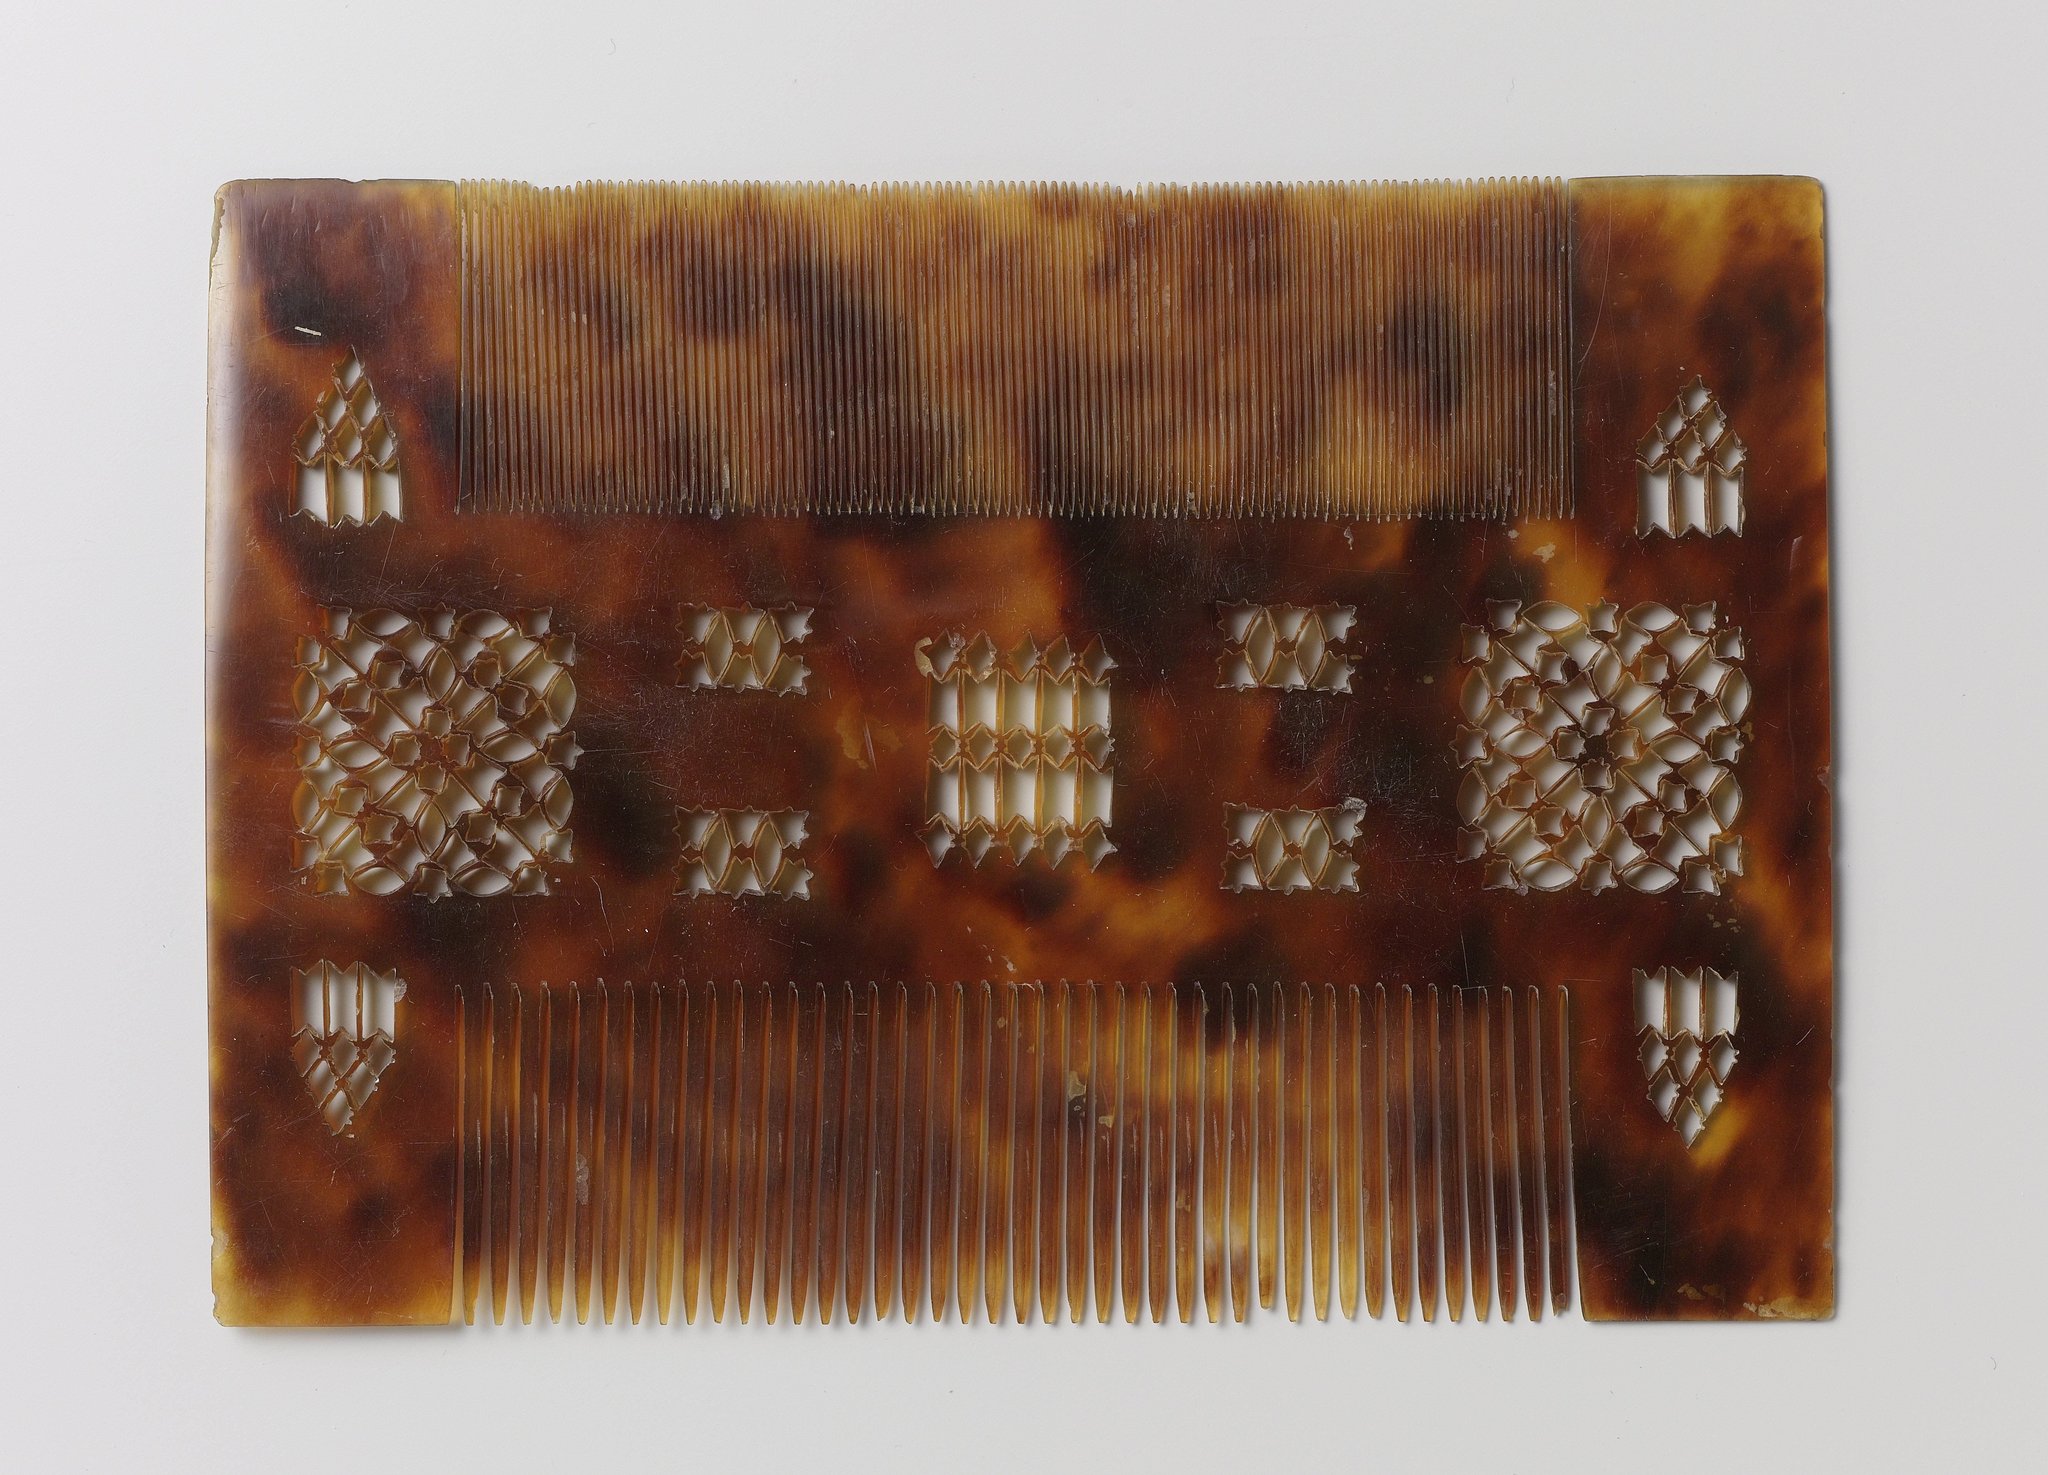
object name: toiletry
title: Haarkam van schildpad met een ajour gesneden middenveld en aan weerszijden tanden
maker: Anonymous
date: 1500-1524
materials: shell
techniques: embroidery, filing, polish, sawing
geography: southern europe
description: Kam van schildpad met een ajourgesneden middenveld en aan weerszijden tanden. In een tijd dat haren niet of nauwelijks werden gewassen werd een kam allereerst gebruikt om het haar te reinigen: te ontdoen van viezigheid en ongedierte. Daarom verschilt ook de dikte van en de afstand tussen de tanden aan weerszijden. Schildpad was een geliefd, maar kostbaar materiaal dat van ver moest komen. Dit blijkt uit een brief die een Antwerpse kunsthandelaar in juni 1640 kreeg van zijn agent in Lissabon. Deze schreef dat schildpadden daar niet te koop waren, maar wél in Sevilla (Spanje) waar zij rechtstreeks aankwamen uit de 'West Indien' (Caraïbisch gebied).